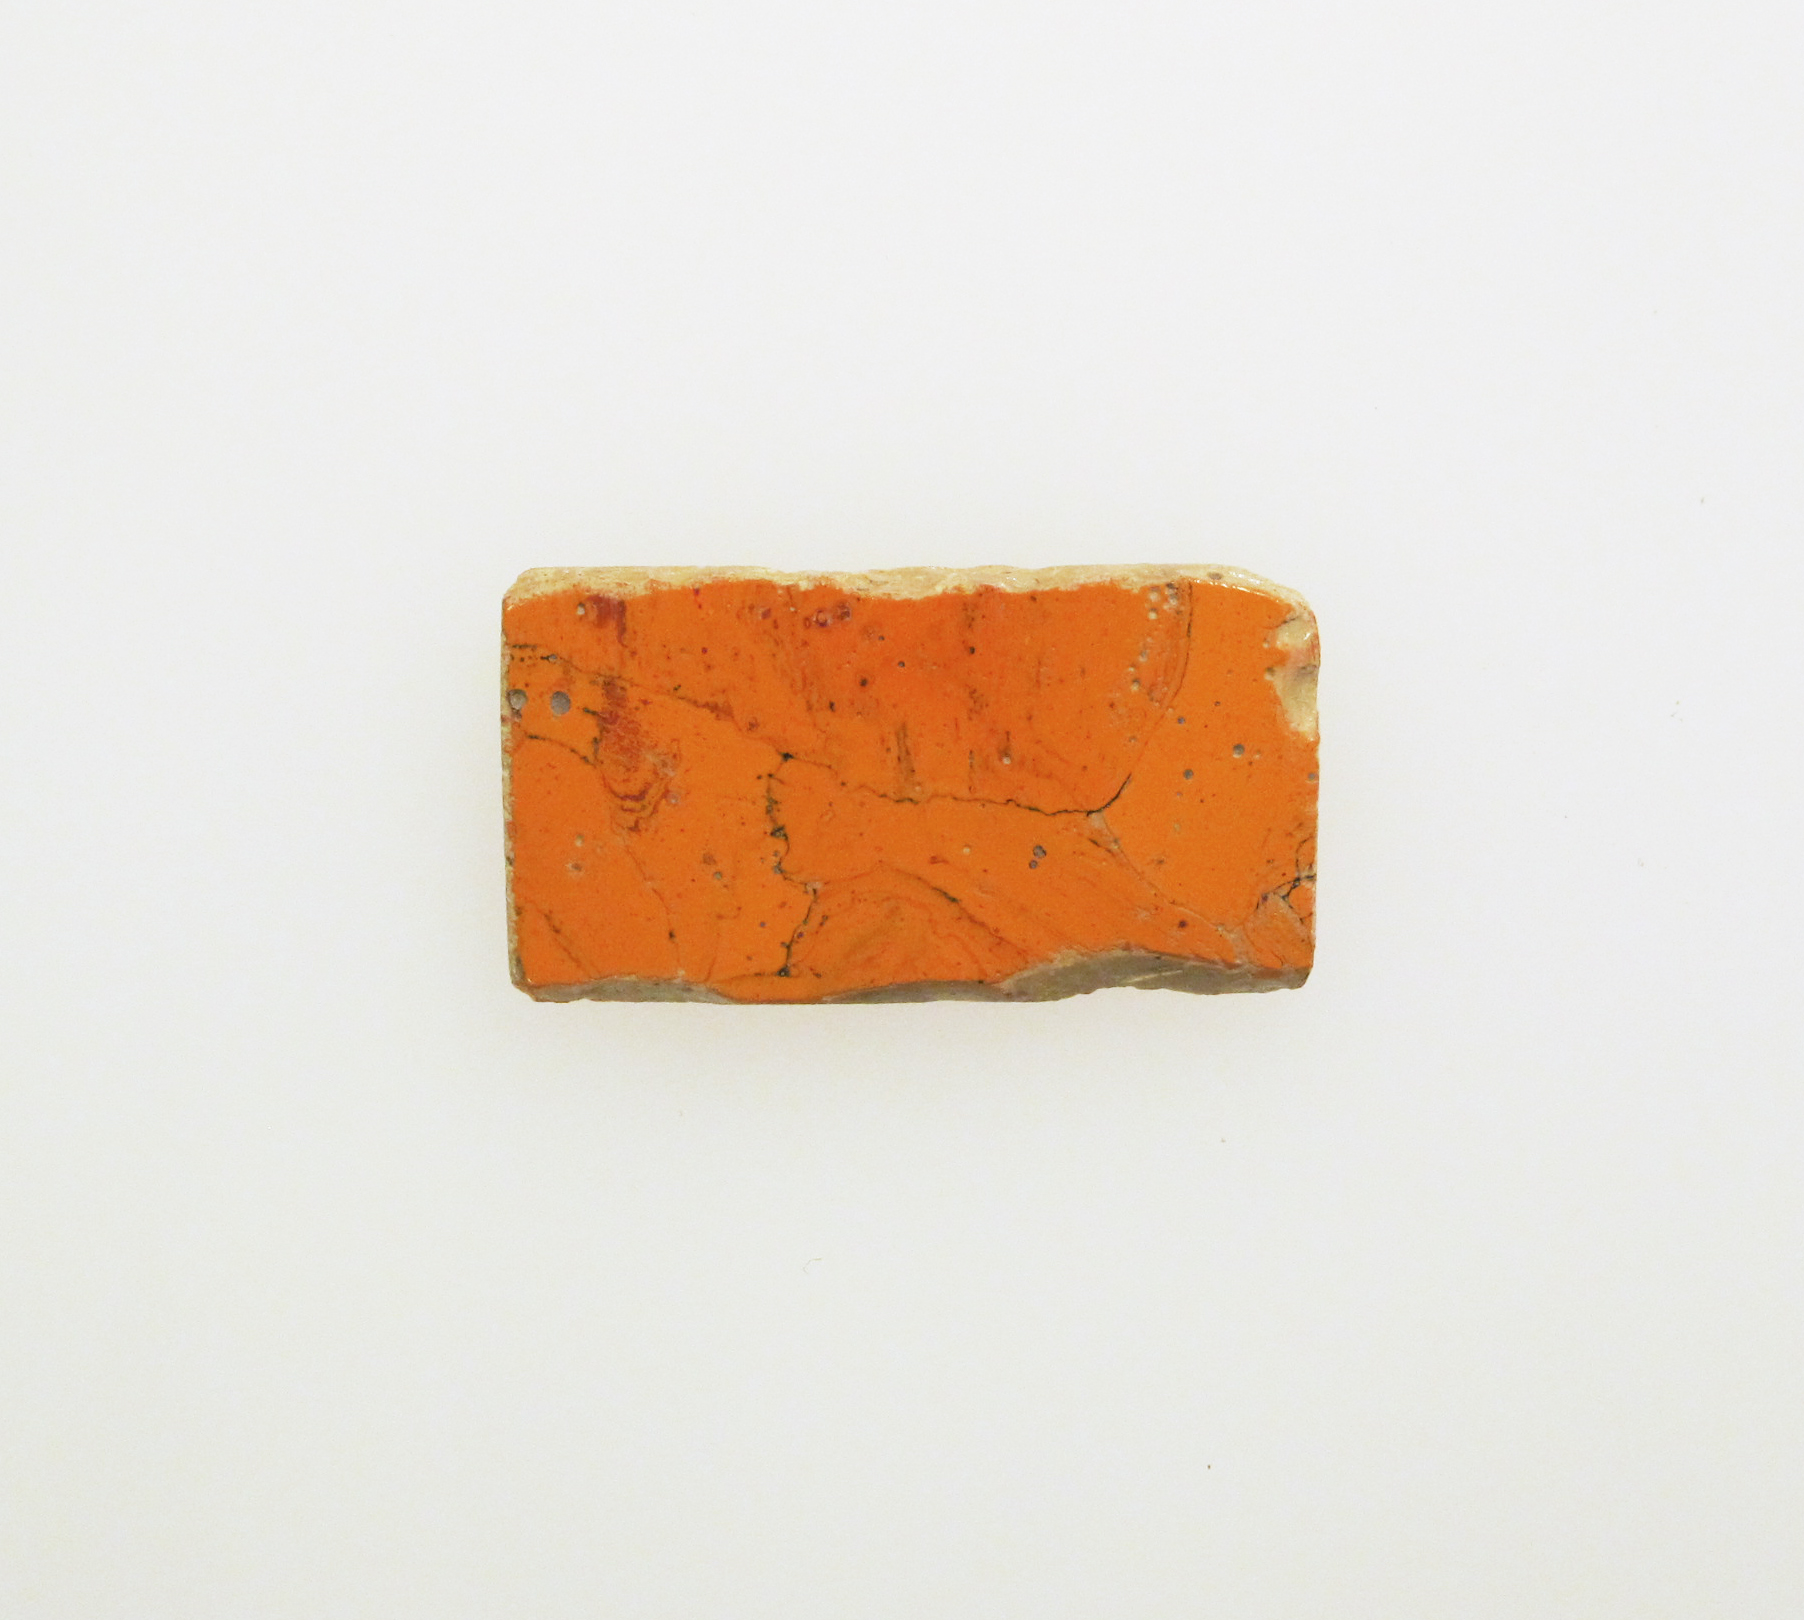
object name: fragment, marbled mosaic inlay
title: Glass marbled mosaic inlay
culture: roman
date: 1-50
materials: glass